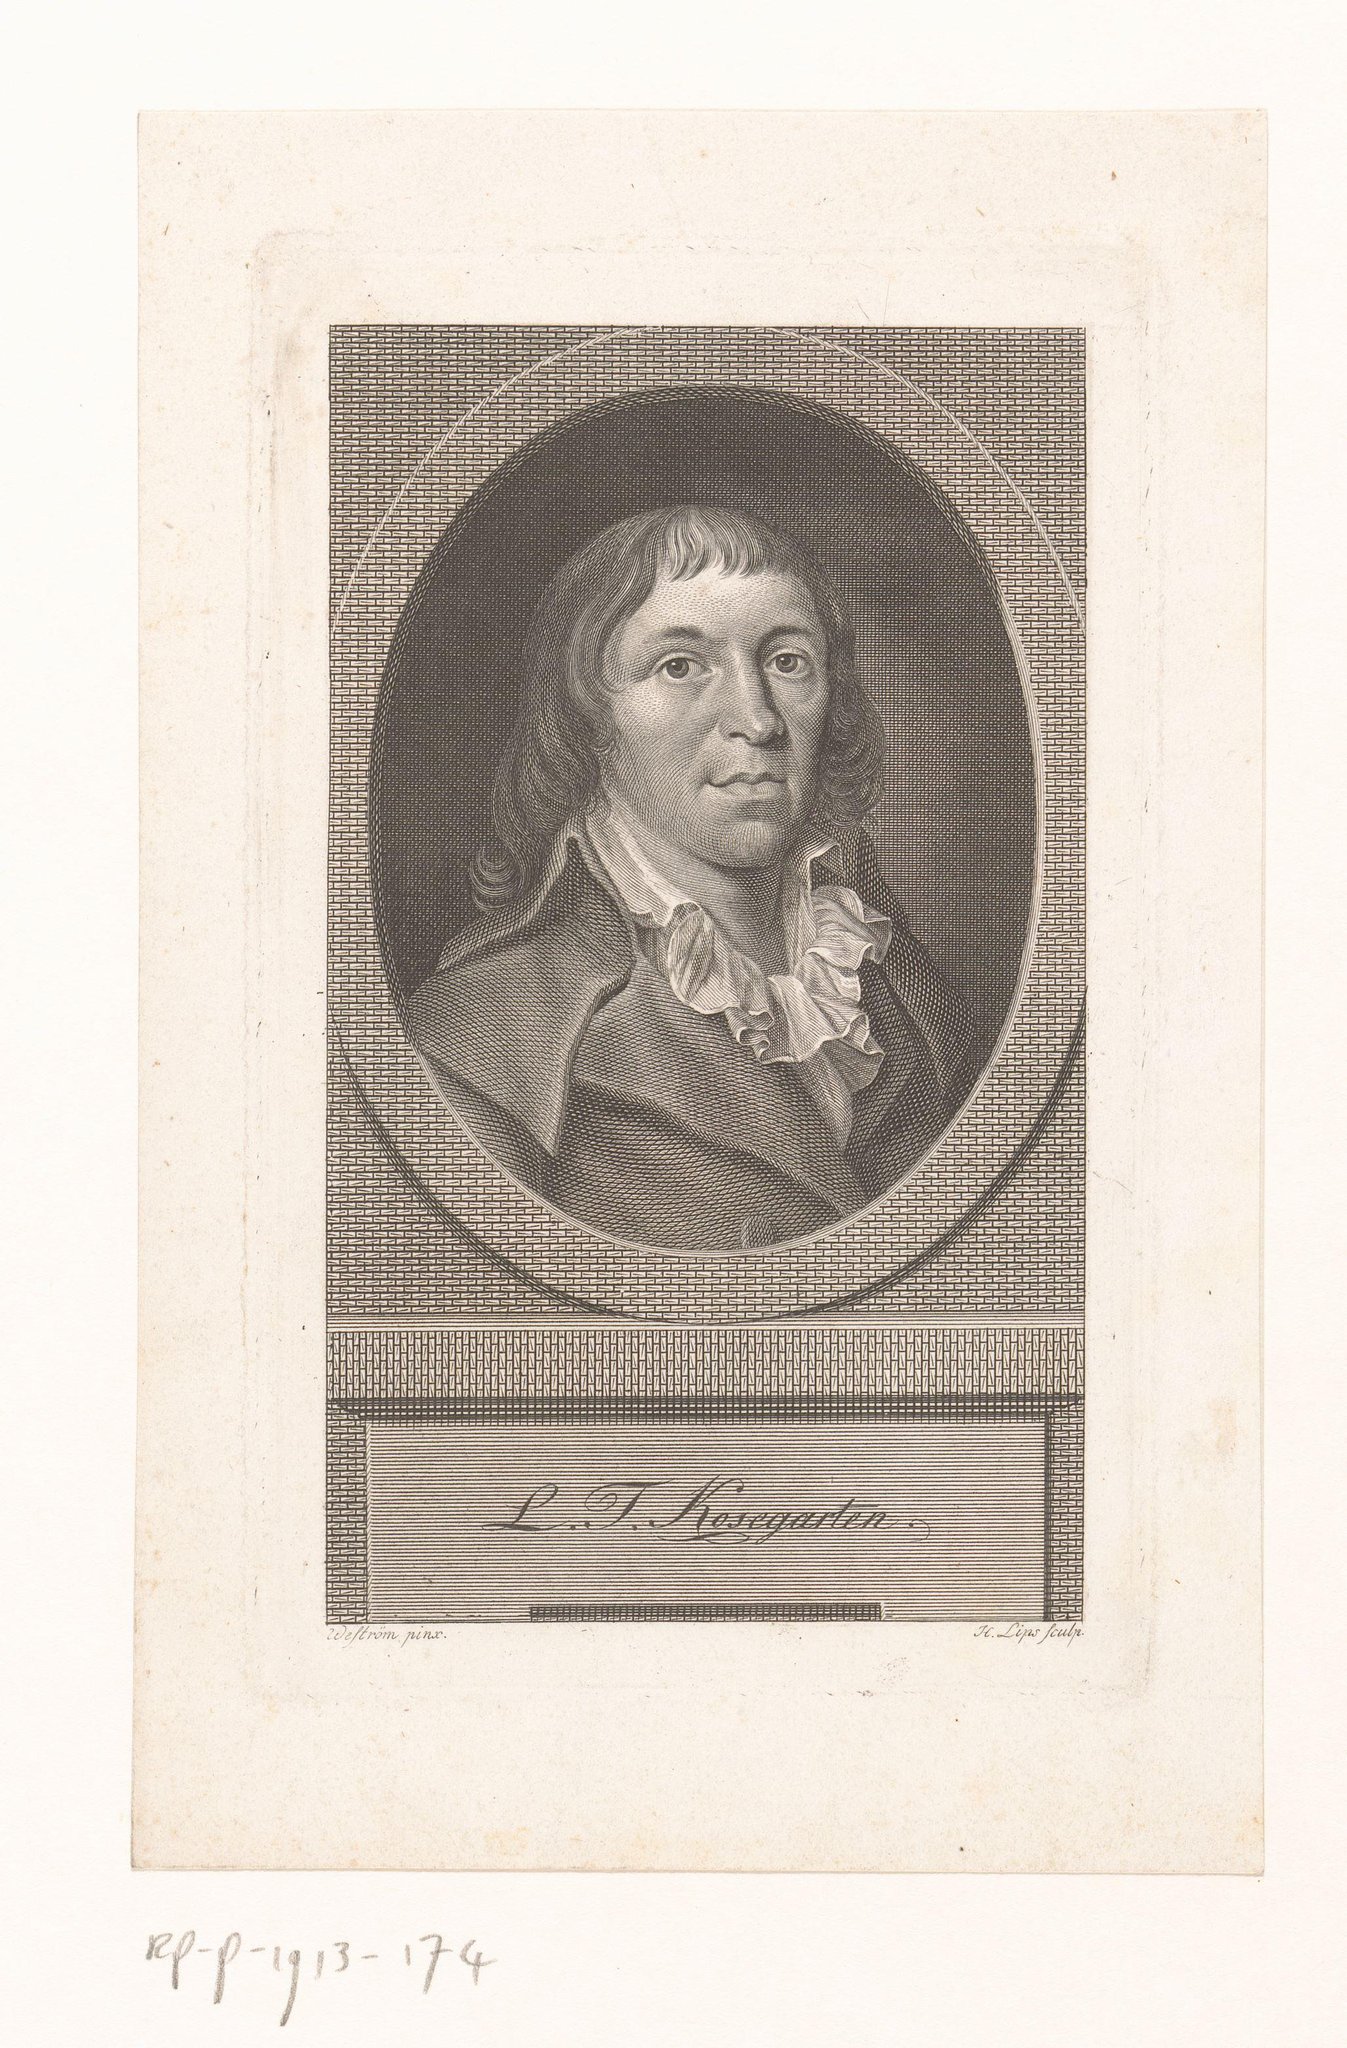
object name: print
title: Portret van Ludwig Gotthard Kosegarten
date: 1768-1817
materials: paper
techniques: engraving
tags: theologian, historical persons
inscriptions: collector's mark: Lugt 2228